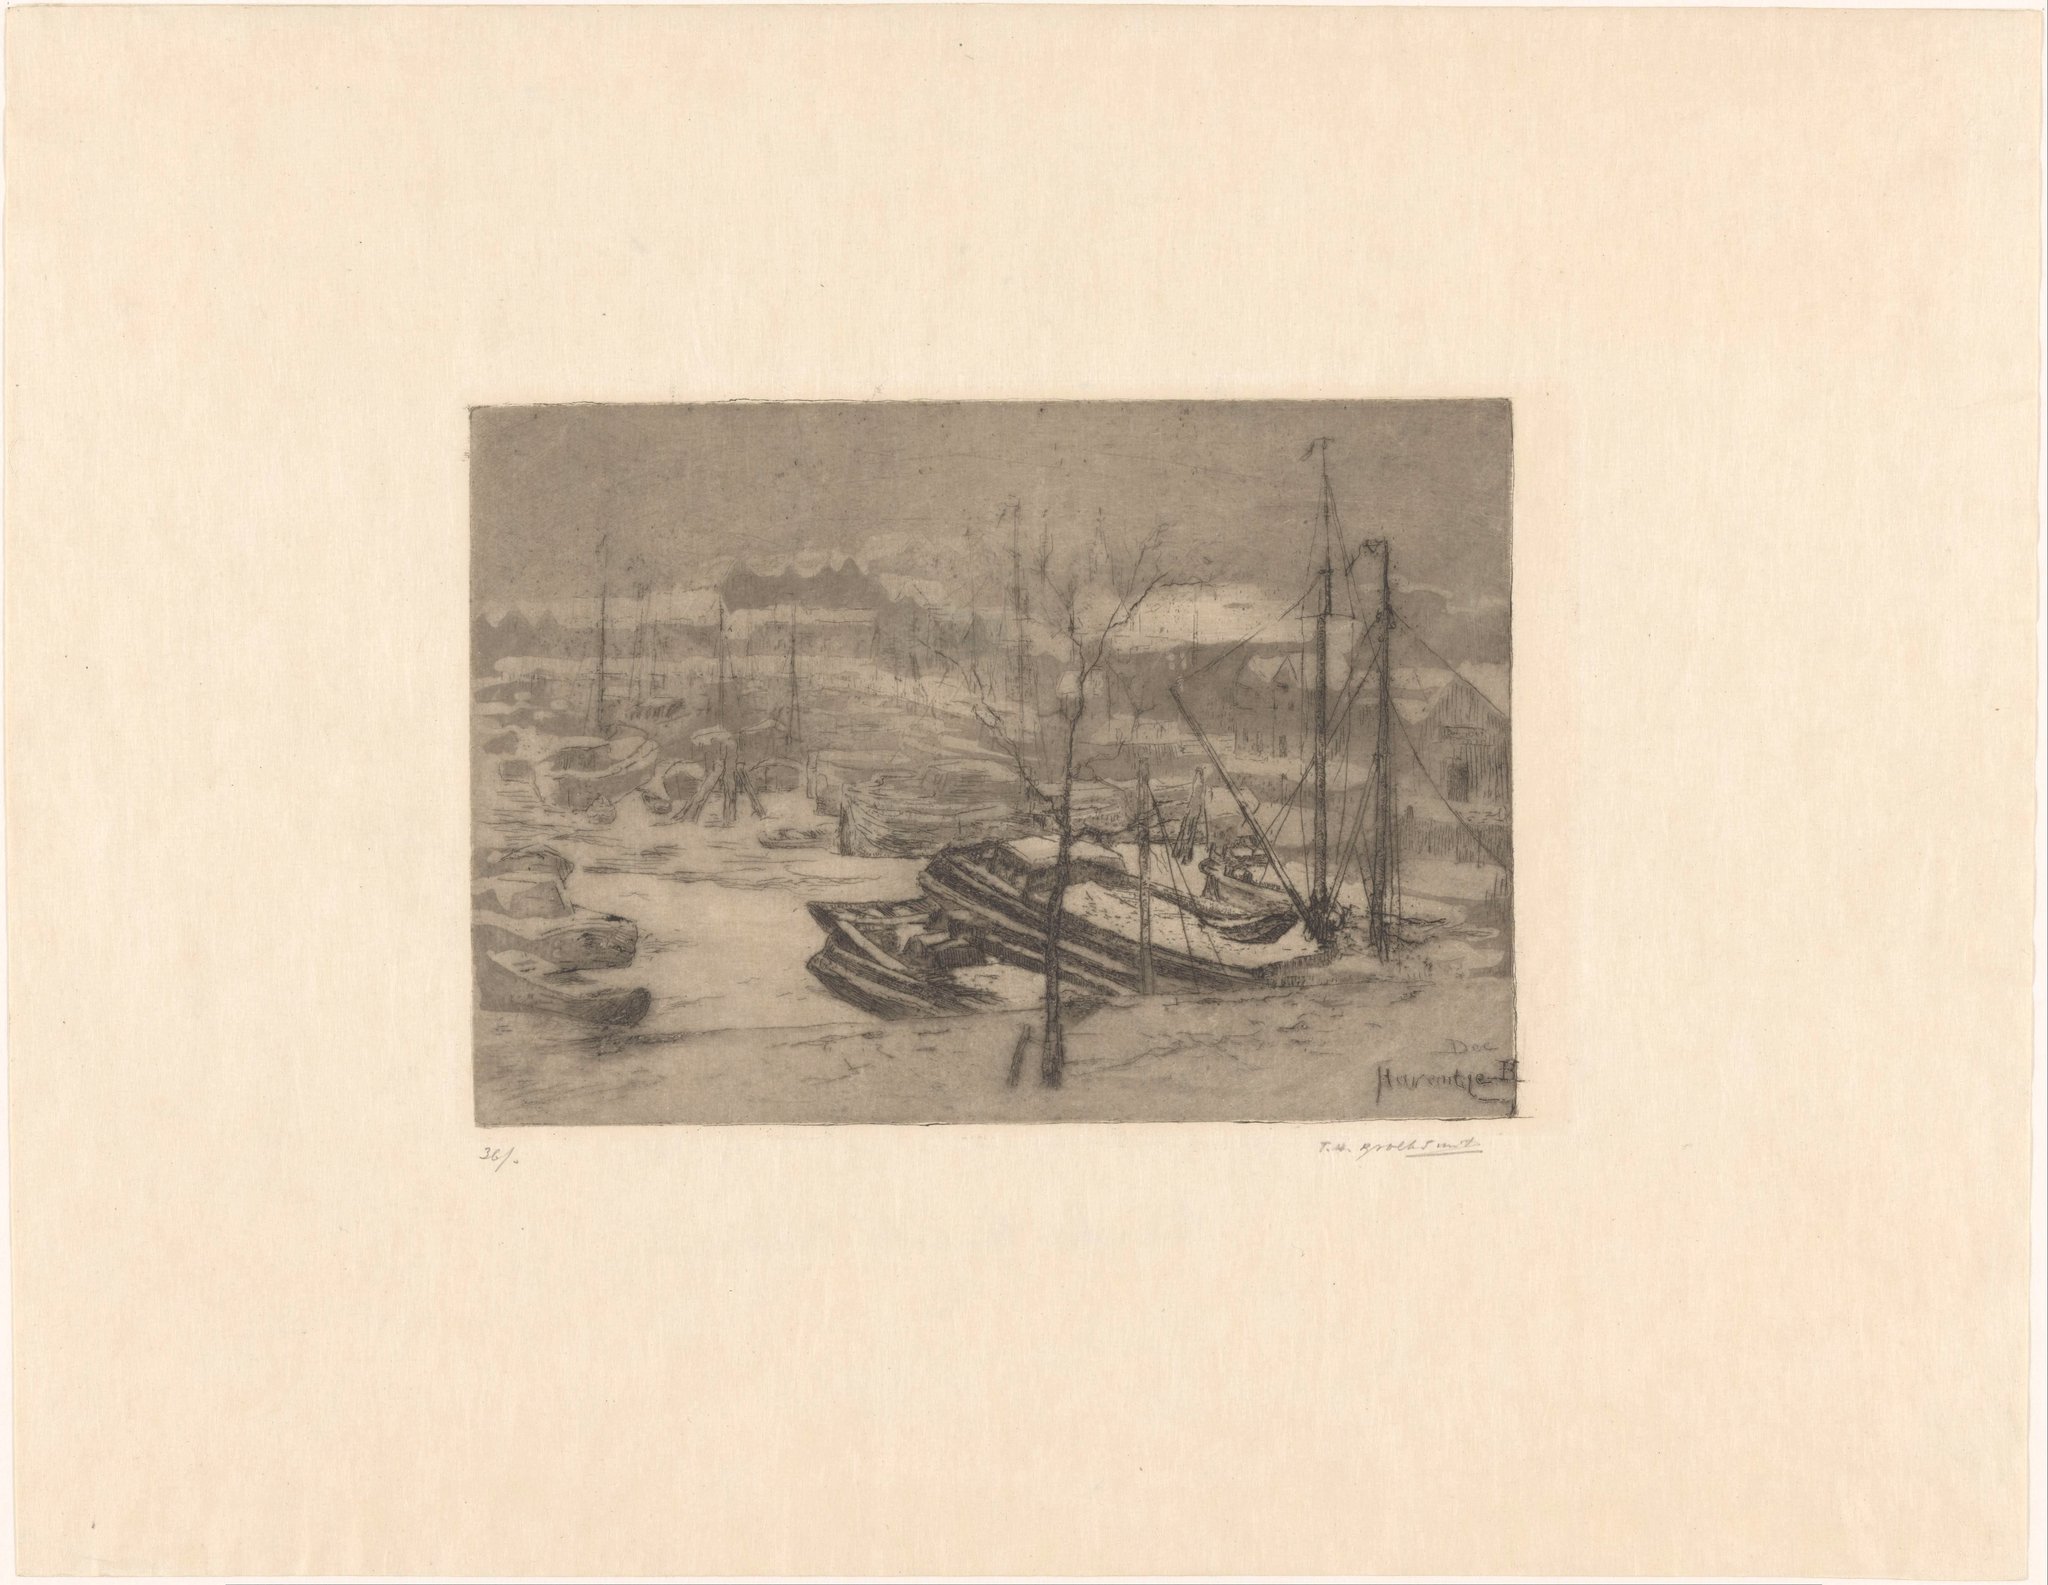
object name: print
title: Haventje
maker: frederika henriëtte broeksmit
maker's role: draughtsman, print maker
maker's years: 1875-1945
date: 1885-1937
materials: paper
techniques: aquatint, etching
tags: harbour, snow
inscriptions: collector's mark: Lugt 2228, collector's mark: Lugt 2760